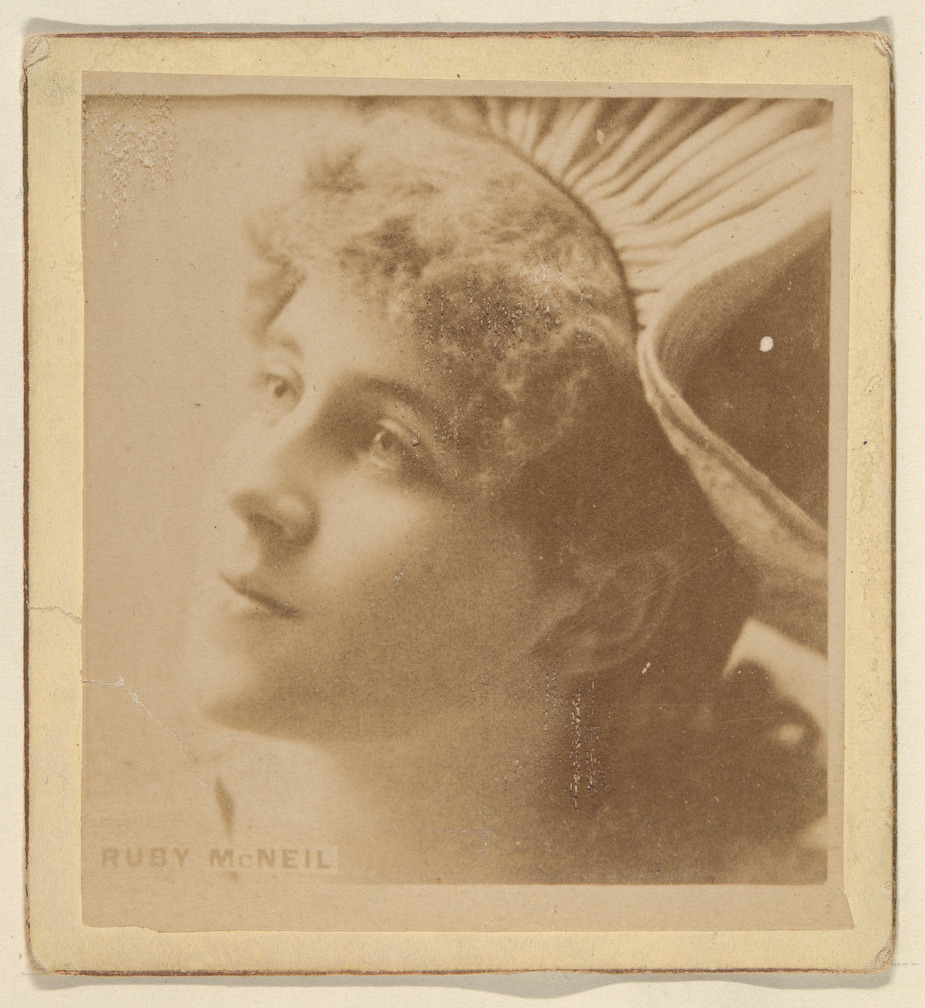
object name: photograph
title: Ruby McNeil, from the Actresses series (N246), Type 2, issued by Kinney Brothers to promote Sporting Extra Cigarettes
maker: kinney brothers tobacco company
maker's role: publisher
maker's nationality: american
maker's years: 1869-2011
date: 1890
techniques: albumen silver print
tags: portraits,women,actresses